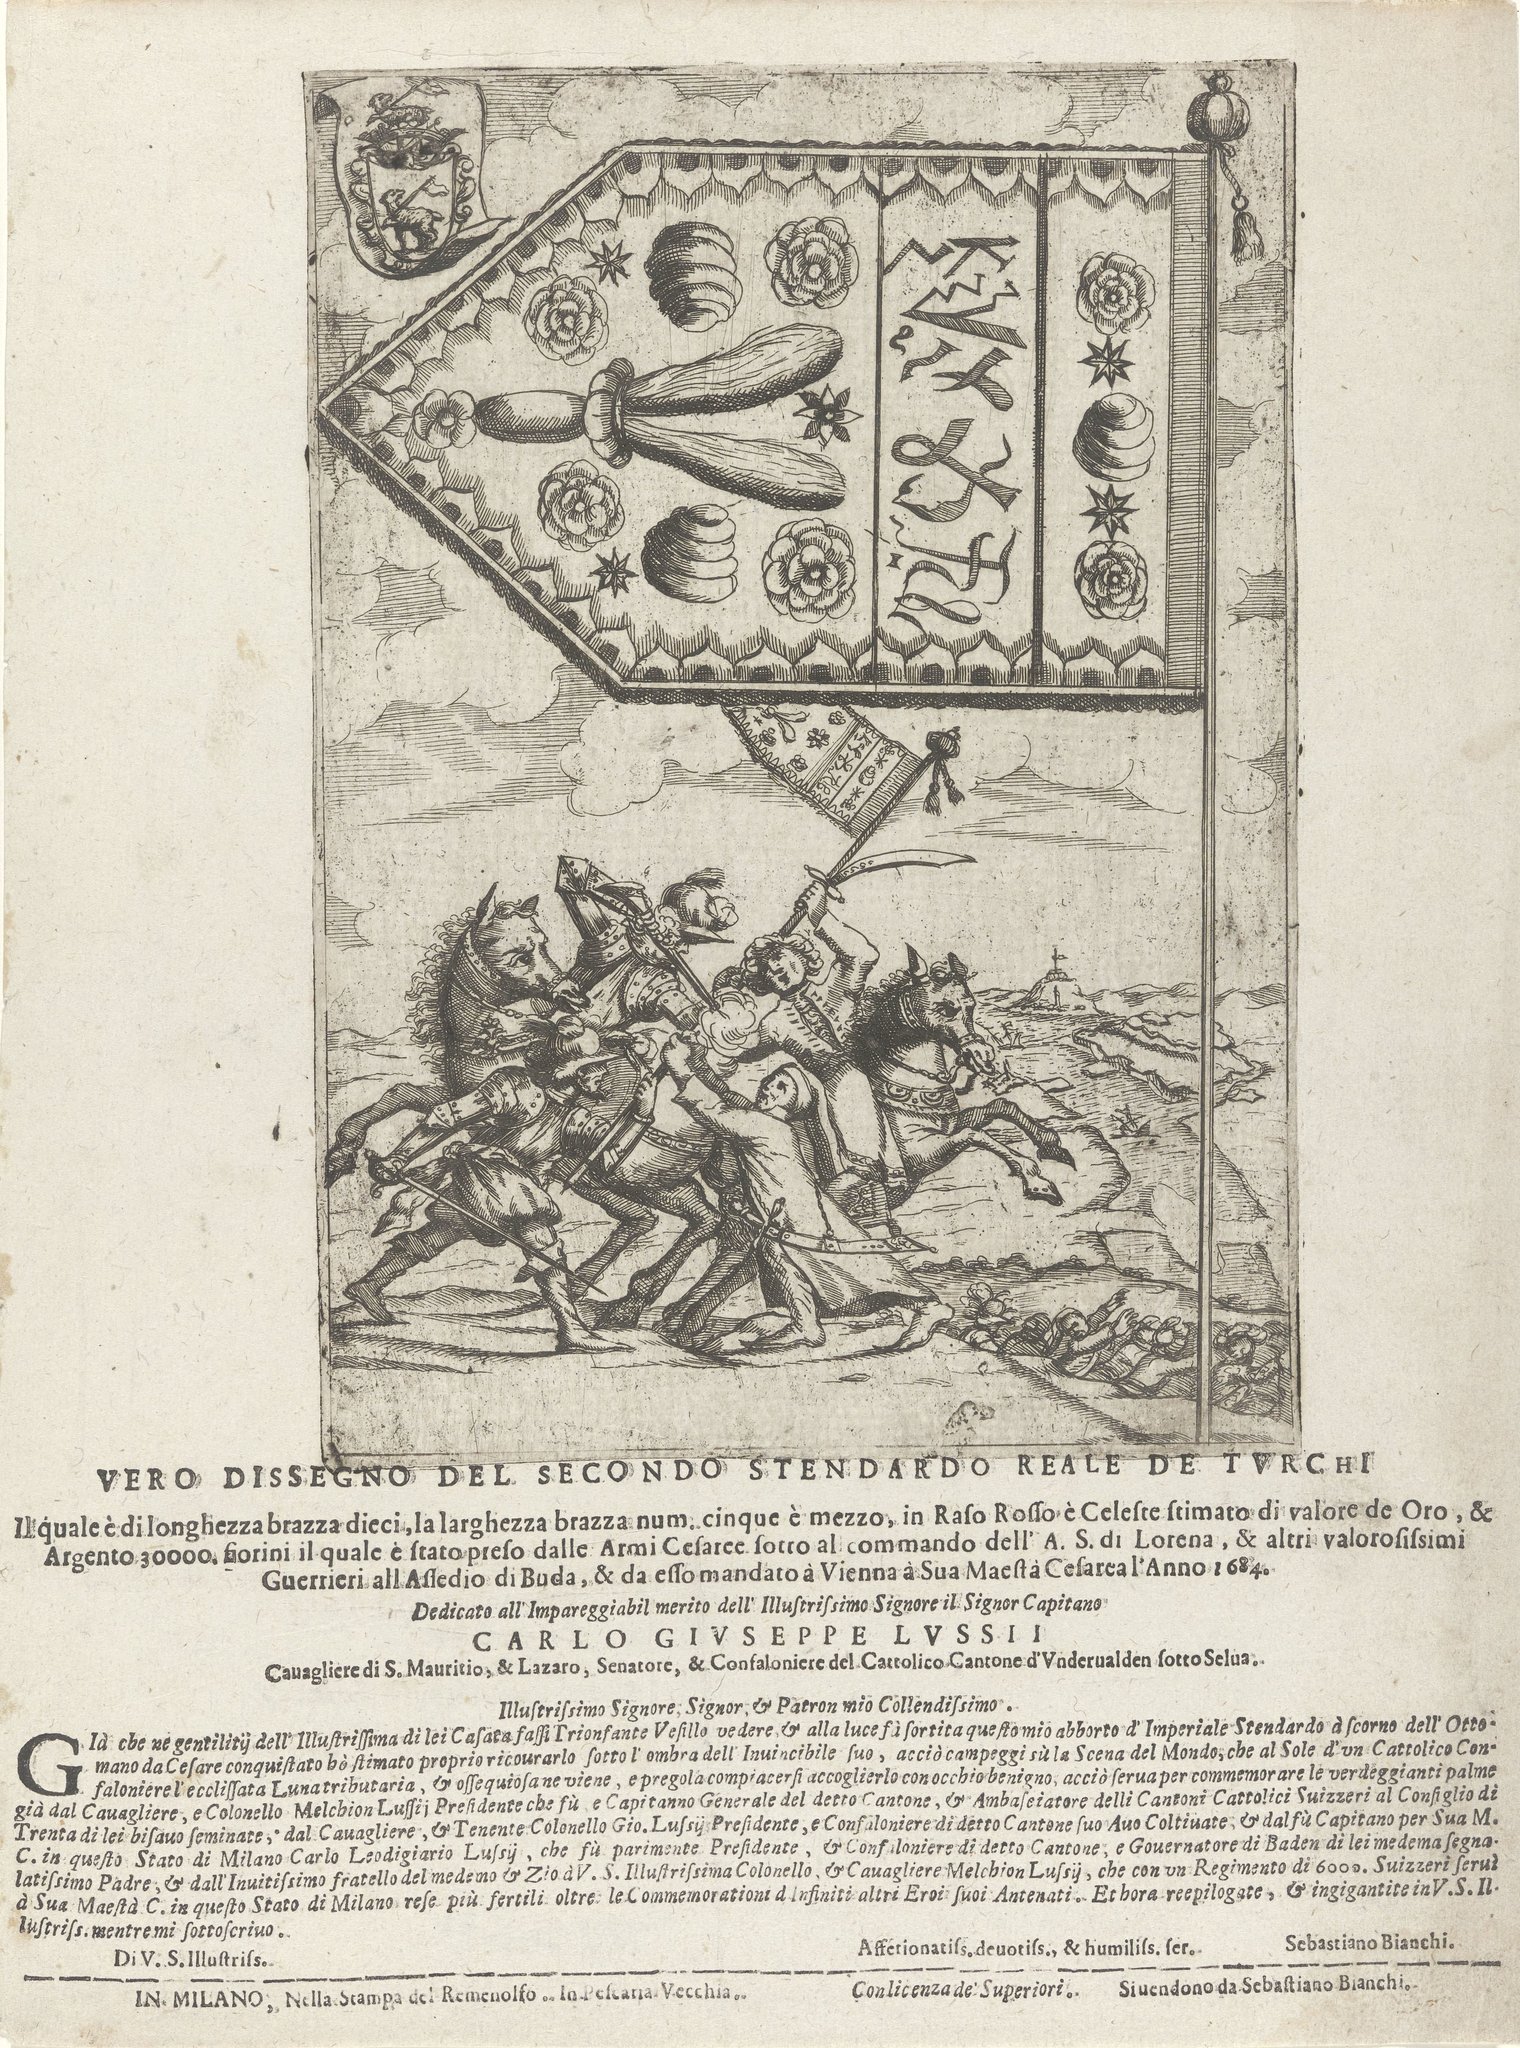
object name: pamphlet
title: Banier van de Turken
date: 1684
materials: paper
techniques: etching, letterpress printing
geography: italy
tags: asiatic races and peoples: turks, battle, banner, standard (as symbol of the state, etc.), the soldier; the soldier's life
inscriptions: date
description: De banier van de Turken. Onder twee soldaten vechtend met twee Turkse mannen in een landschap. Tekst in boekdruk onder de voorstelling